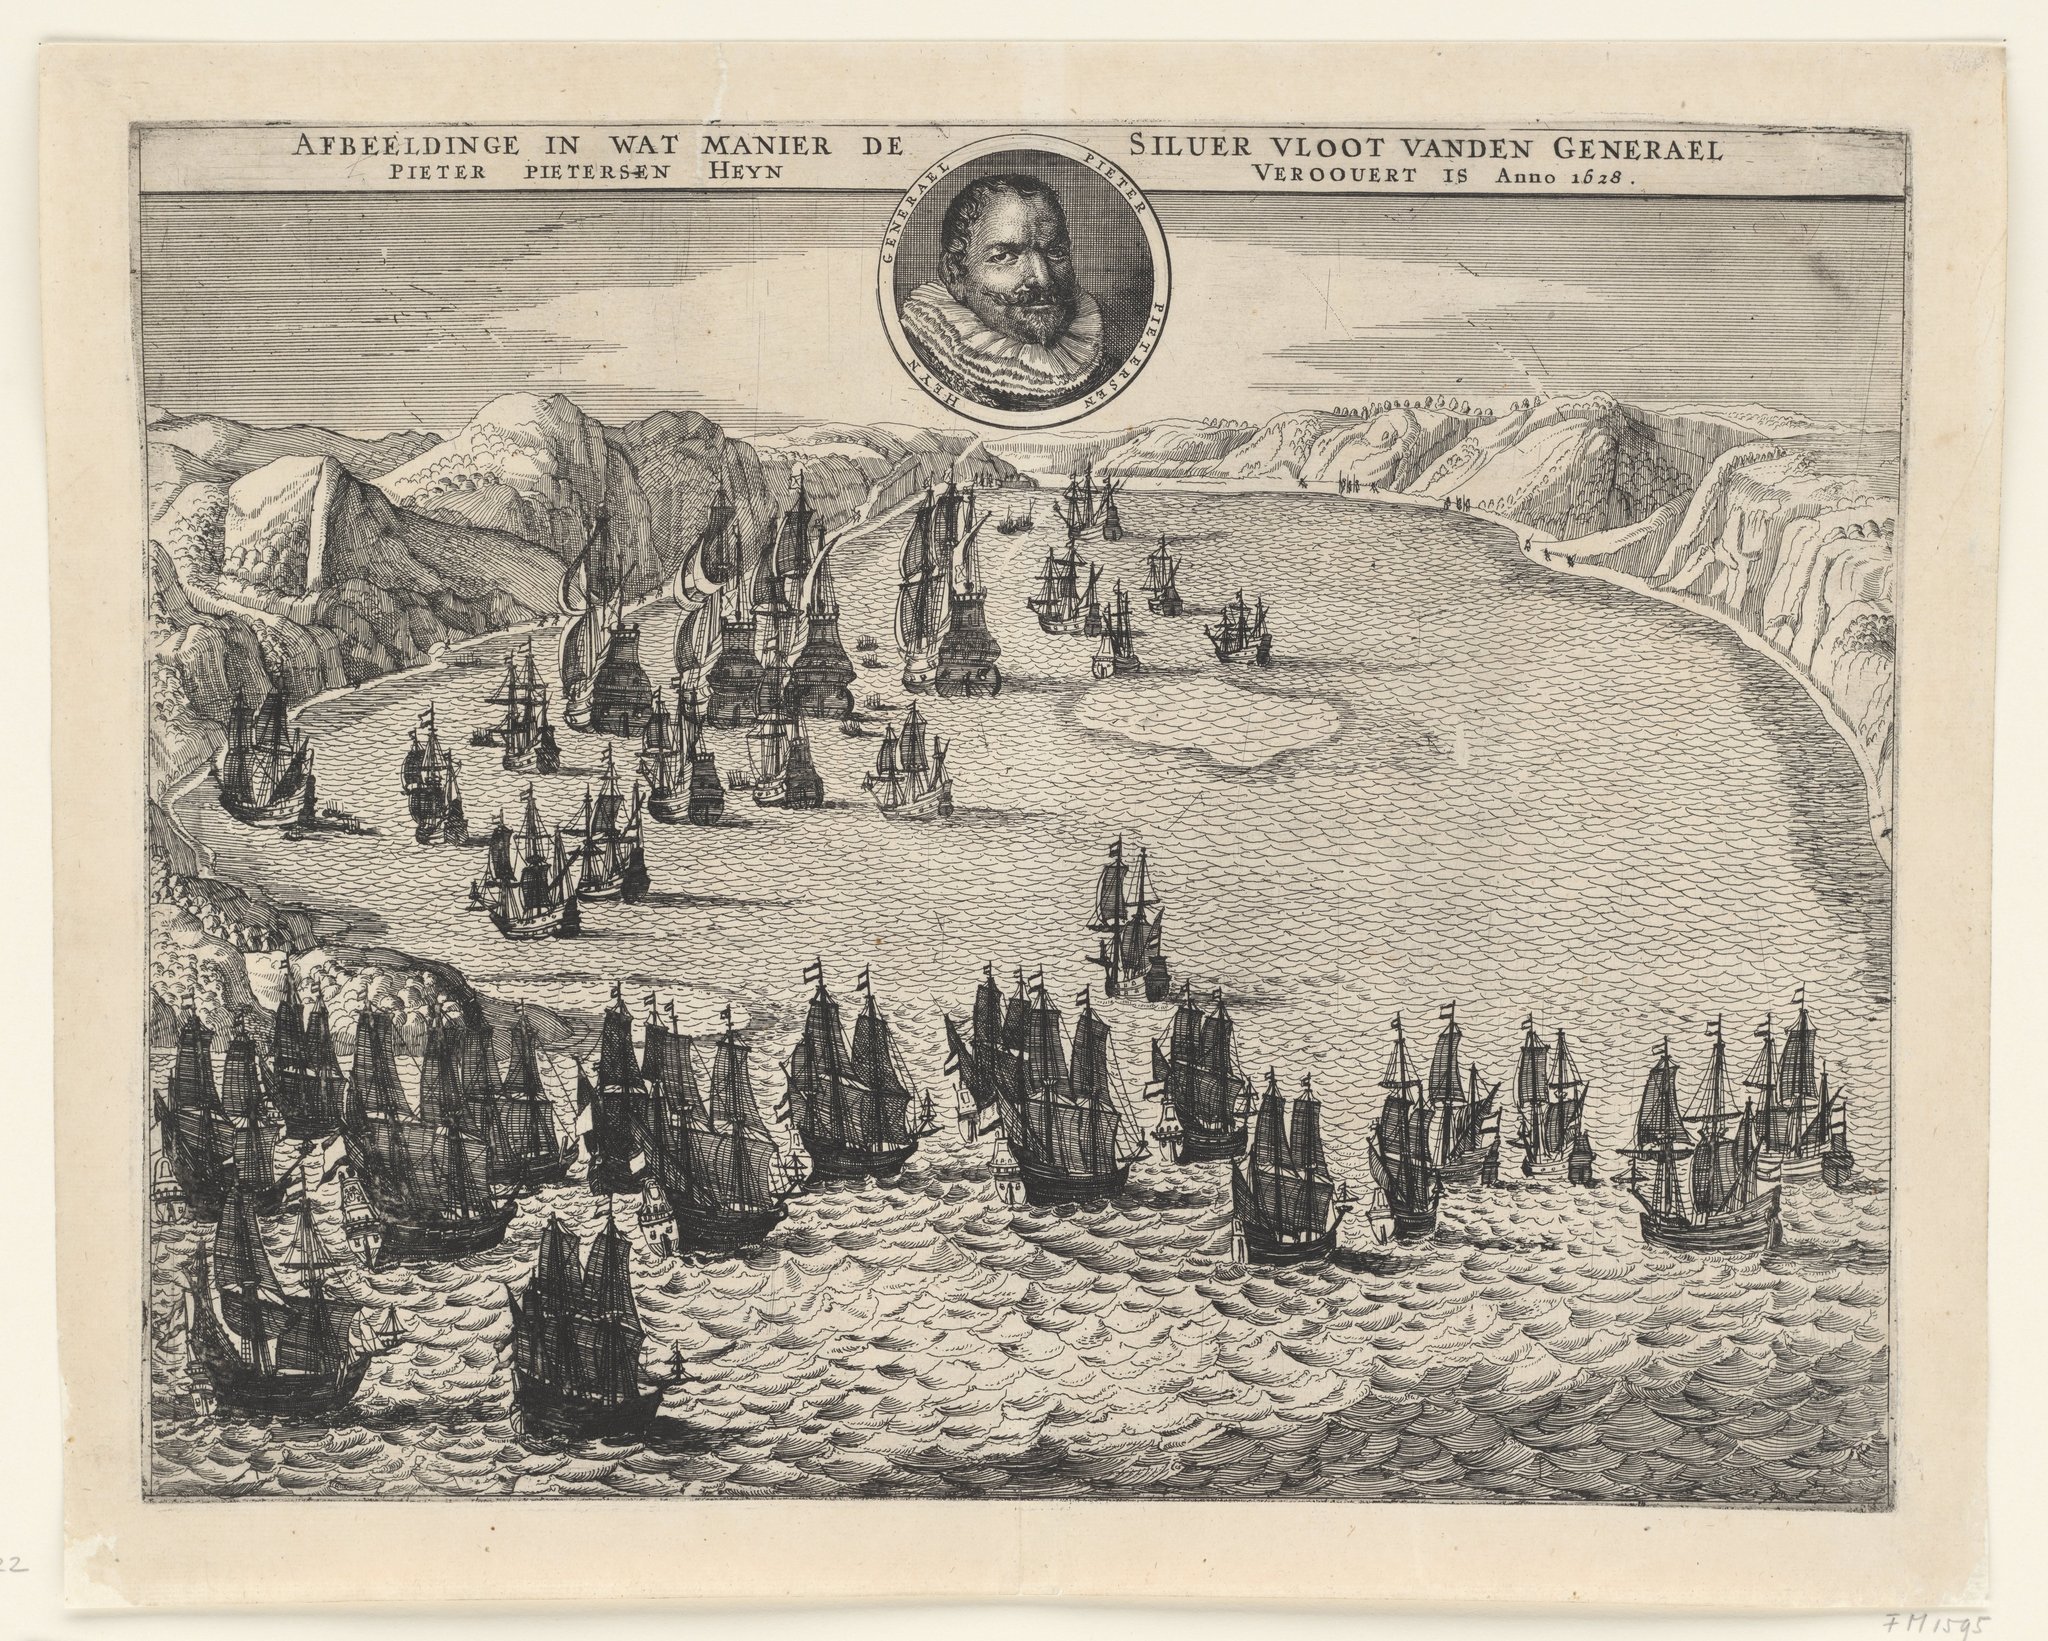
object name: print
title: Afbeeldinge in wat manier de Silver vloot vanden Generael Pieter Pietersen Heyn veroovert is Anno 1628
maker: Anonymous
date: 1651-1652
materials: paper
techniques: etching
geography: northern netherlands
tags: delfshaven, ships (in general) (+ propulsion of vehicle, ship, etc. by wind), capture of the spanish treasure fleet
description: Gebruikt als illustratie in: I. Commelin, Frederick Hendrick van Nassauw prince van Orangien zyn leven en bedryf, Wed. Esdras Willemsz Snellaert en Gerrit Nieuwenhuysen, Utrecht 1652, fol. 45 (?). Spiegelbeeldige kopie naar de prent in de uitgave van Jodocus Janssonius van 1651 (FMH 1595).